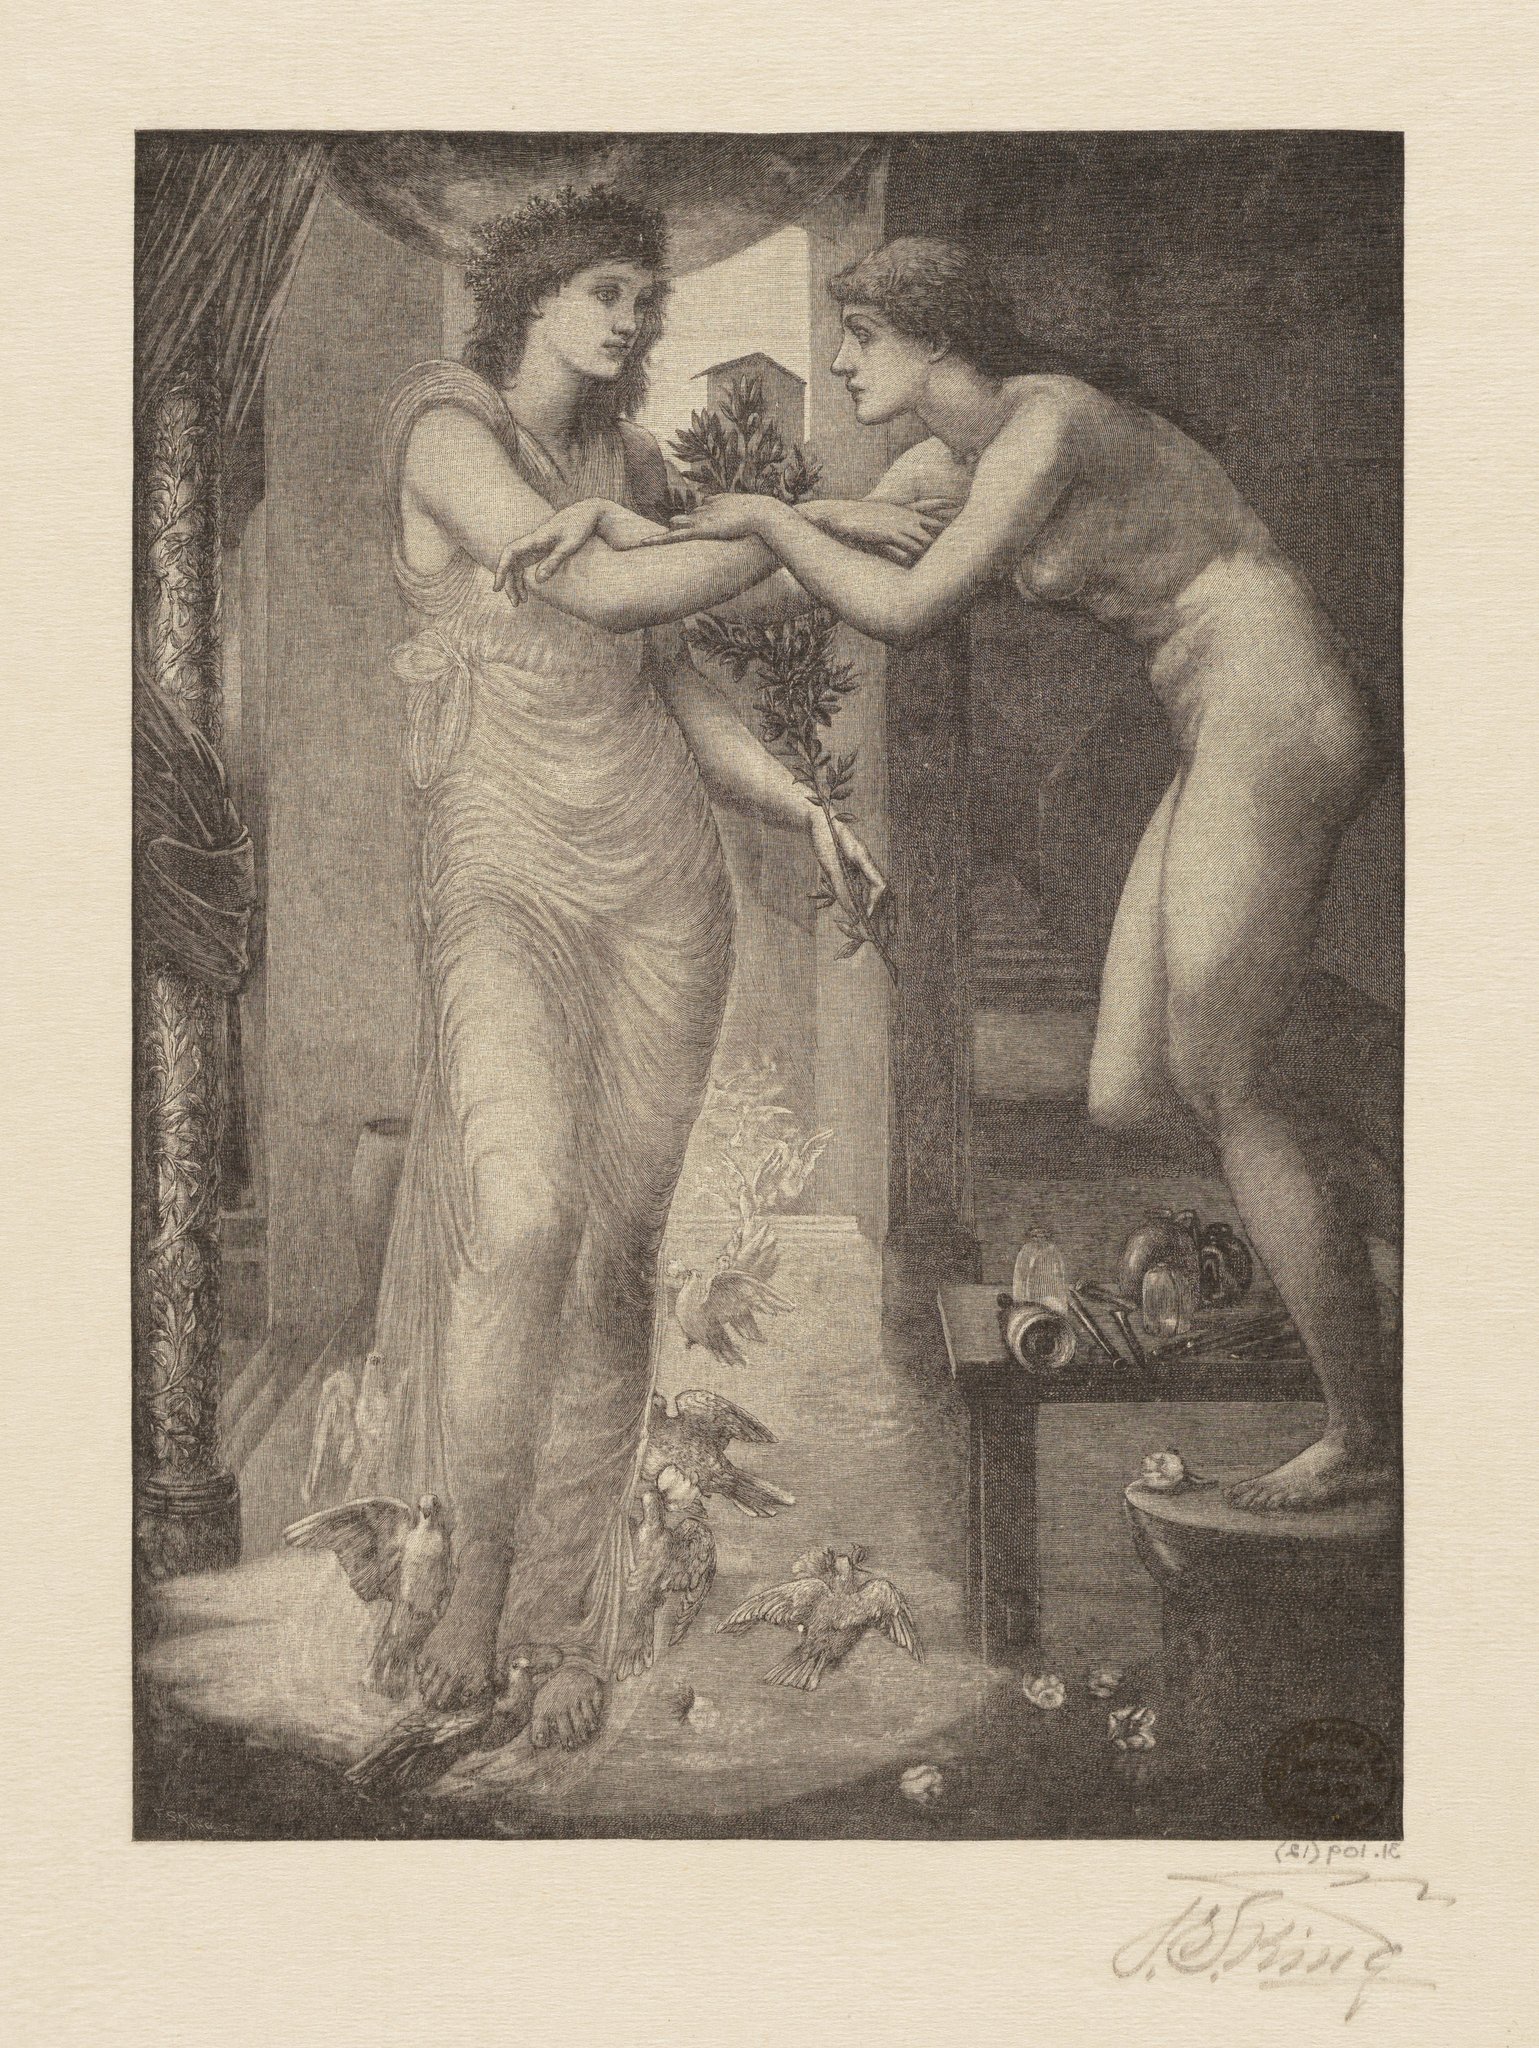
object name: print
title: The God-Head Fires, after Burne-Jones, from "Art of the American Wood-Engraver. Forty India Proofs to Accompany the Text of Philip Gilbert Hamerton"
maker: francis scott king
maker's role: engraver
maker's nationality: american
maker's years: 1850-1913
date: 1894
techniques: engraving